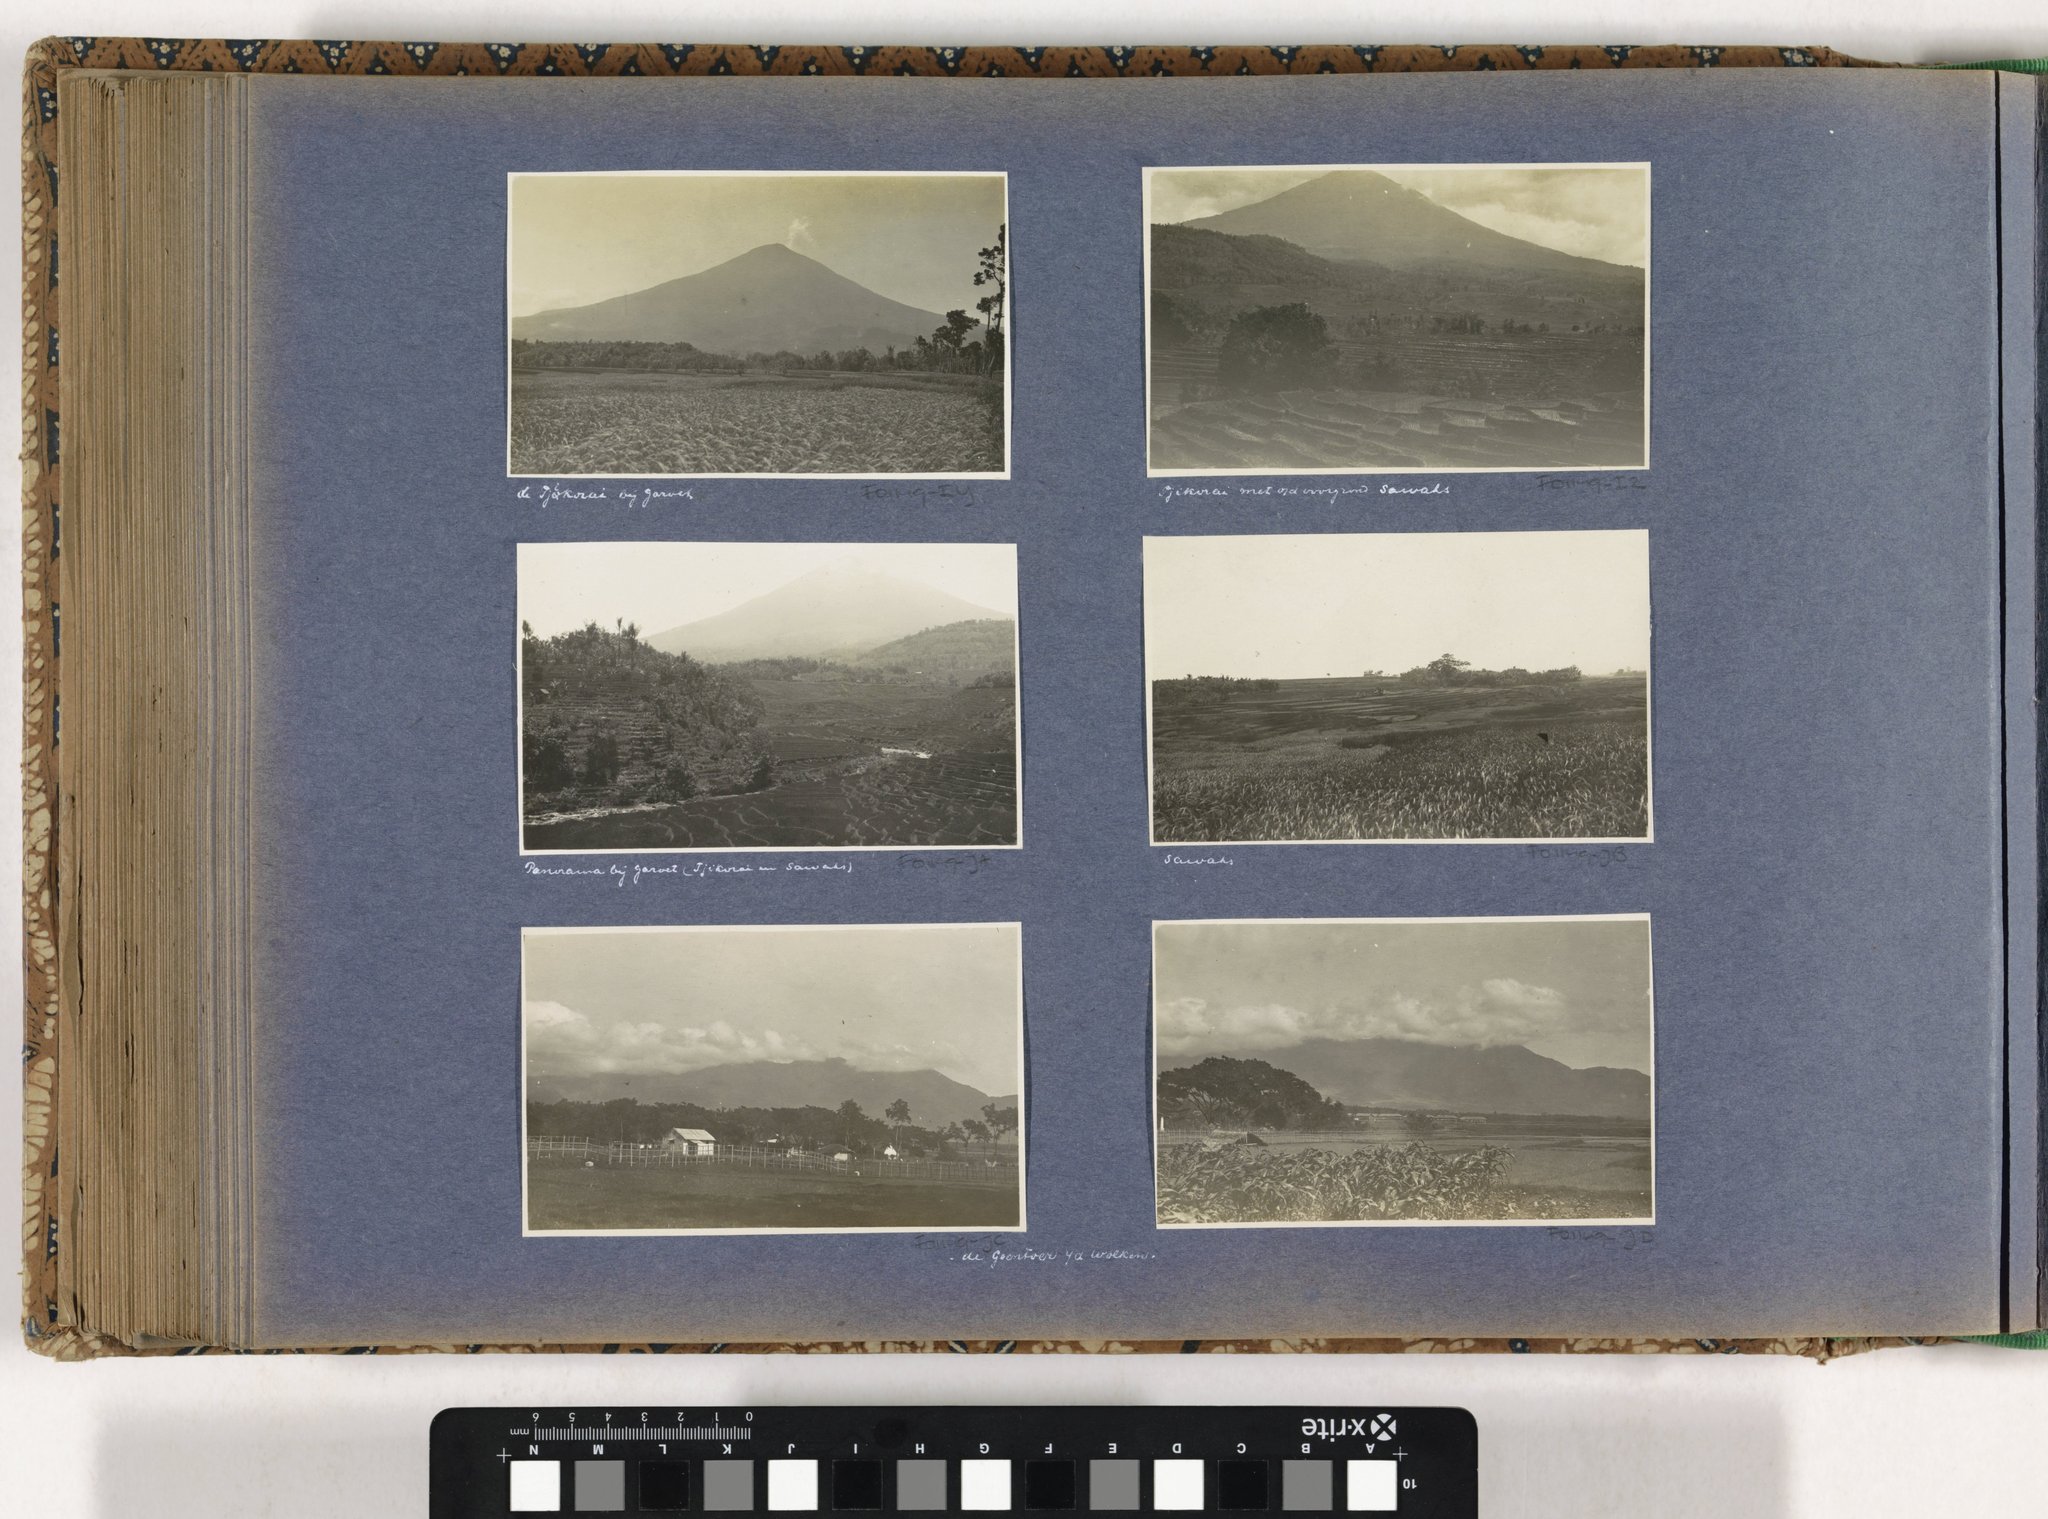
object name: photograph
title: Sawa's bij Garut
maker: Anonymous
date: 1900-1920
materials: paper, photographic support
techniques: gelatin silver print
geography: garut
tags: sawahs, rice paddies, java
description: Onderdeel van reisalbum met foto's van bedrijvigheid en bezienswaardigheden op Sumatra en Java en van de reis naar en van Nederlands-Indië.